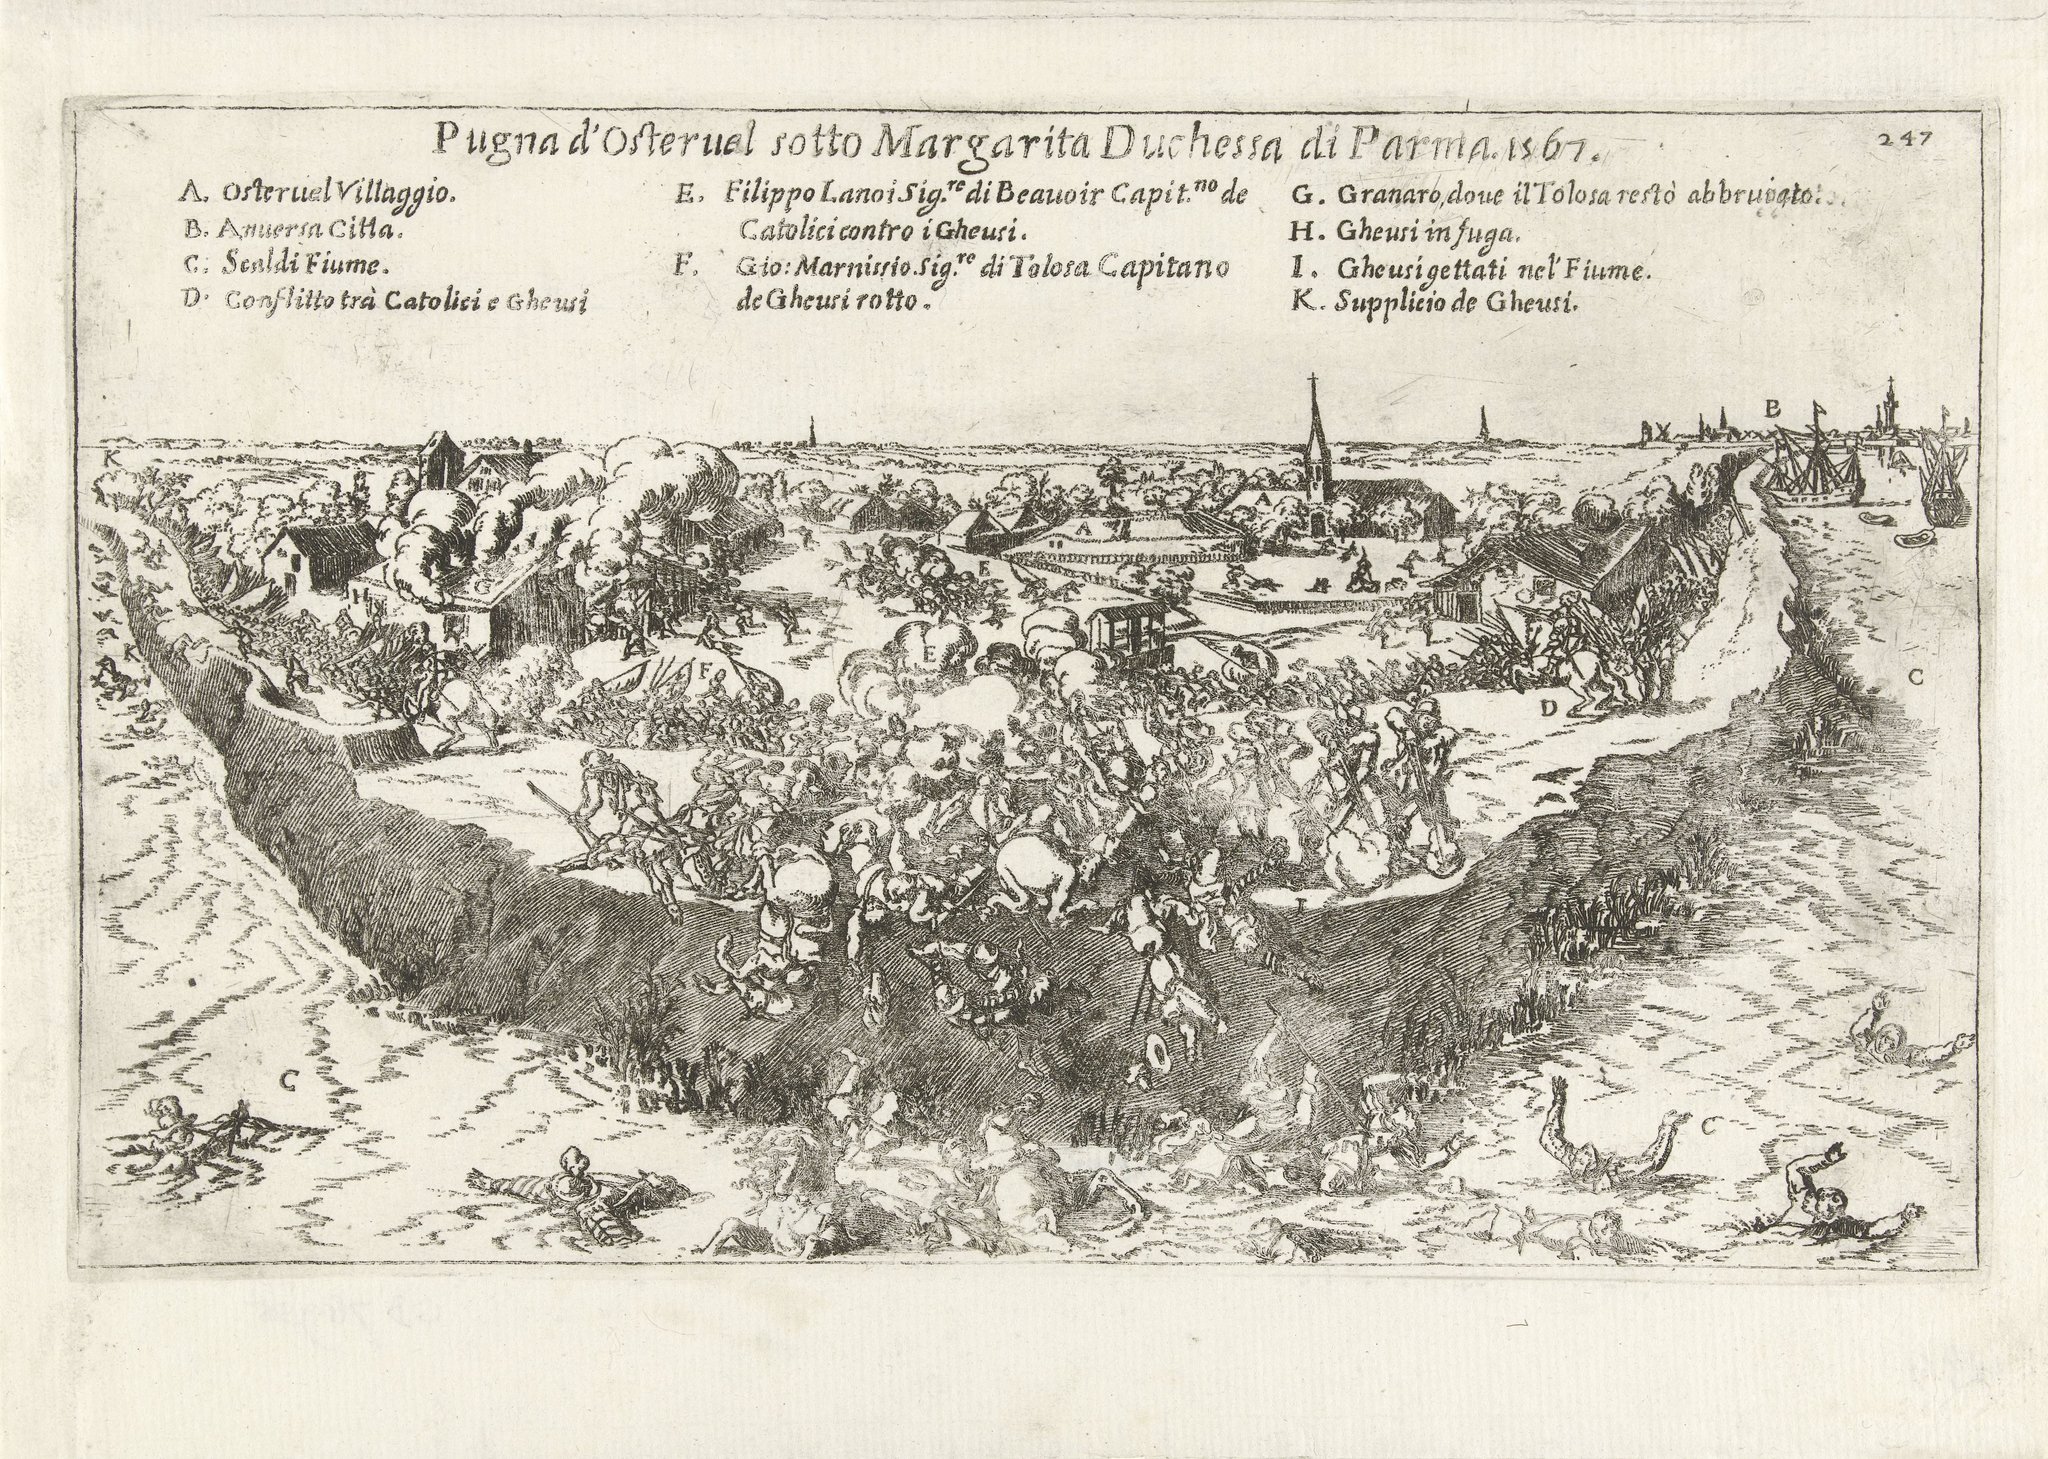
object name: print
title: Pugna d'Ostervel sotto Margarita Duchessa di Parma. 1567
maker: Anonymous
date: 1632-1699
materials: paper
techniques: etching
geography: italy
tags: battle, fighting in general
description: Slag bij Oosterweel, 13 maart 1567. De gevechten voor het dorpje Oosterweel buiten Antwerpen. De calvinisten onder leiding van Jan van Marnix worden verslagen door de troepen van de hertog van Aremberg en Philips van Lanoy. Rechts de Schelde. Boven in de plaat de titel en de legenda A-K in het Italiaans.